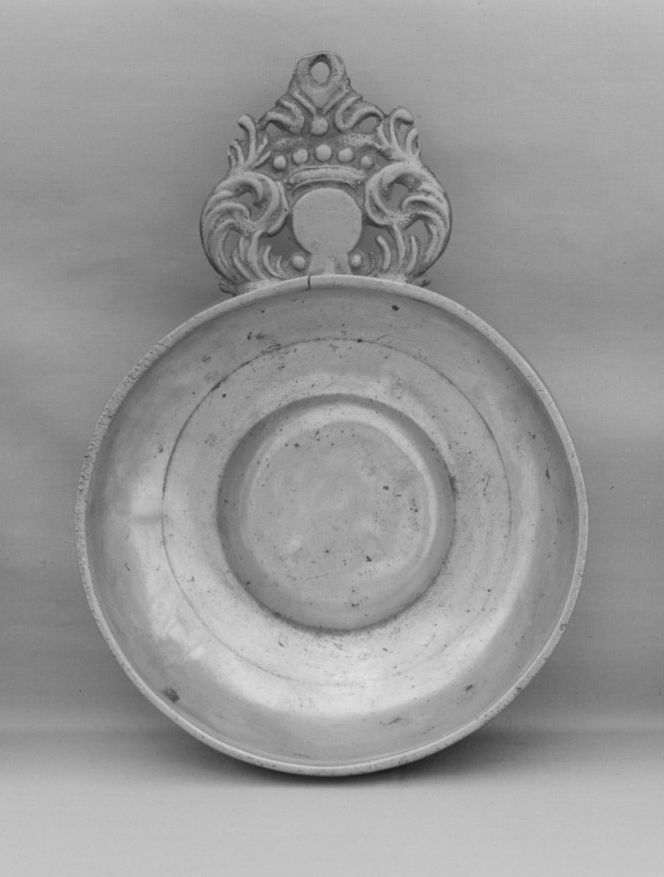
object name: porringer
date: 1770-1830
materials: pewter